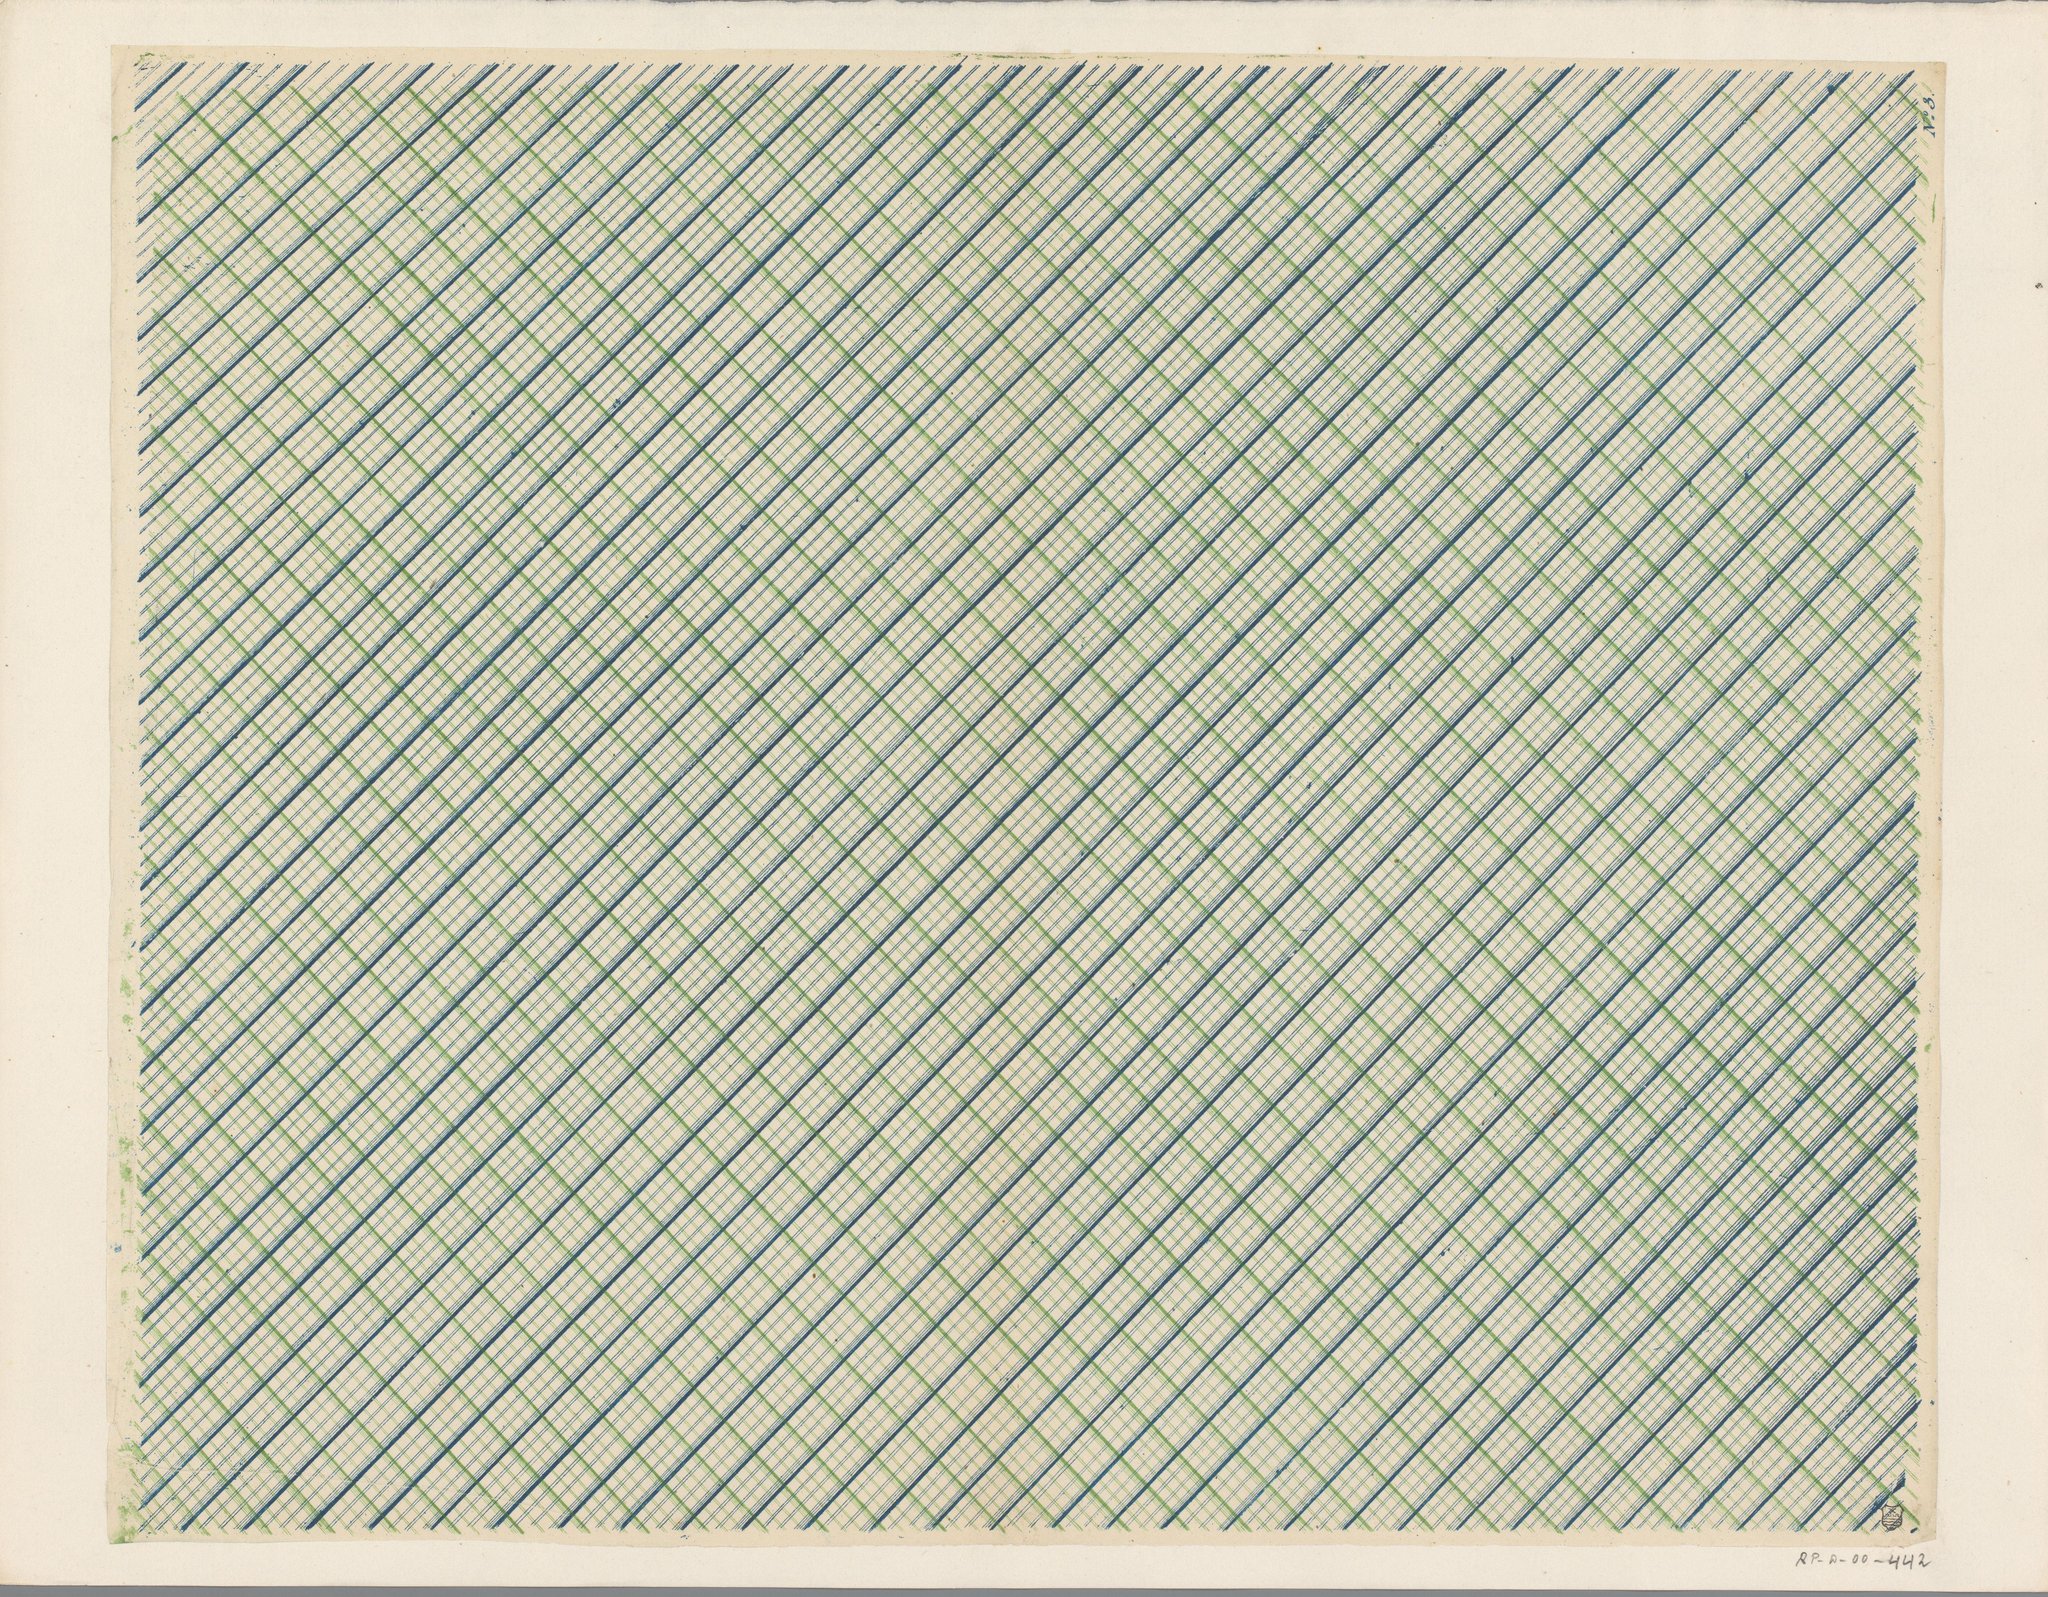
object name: printed paper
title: Blad met ruitpatroon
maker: Anonymous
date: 1800-1900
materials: paper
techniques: printing block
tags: ornament ~ straight lines (right angles only)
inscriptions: collector's mark: Lugt 2760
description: Blad met ruitpatroon van diagonale lijnen. Genummerd rechtsboven: No. 3.